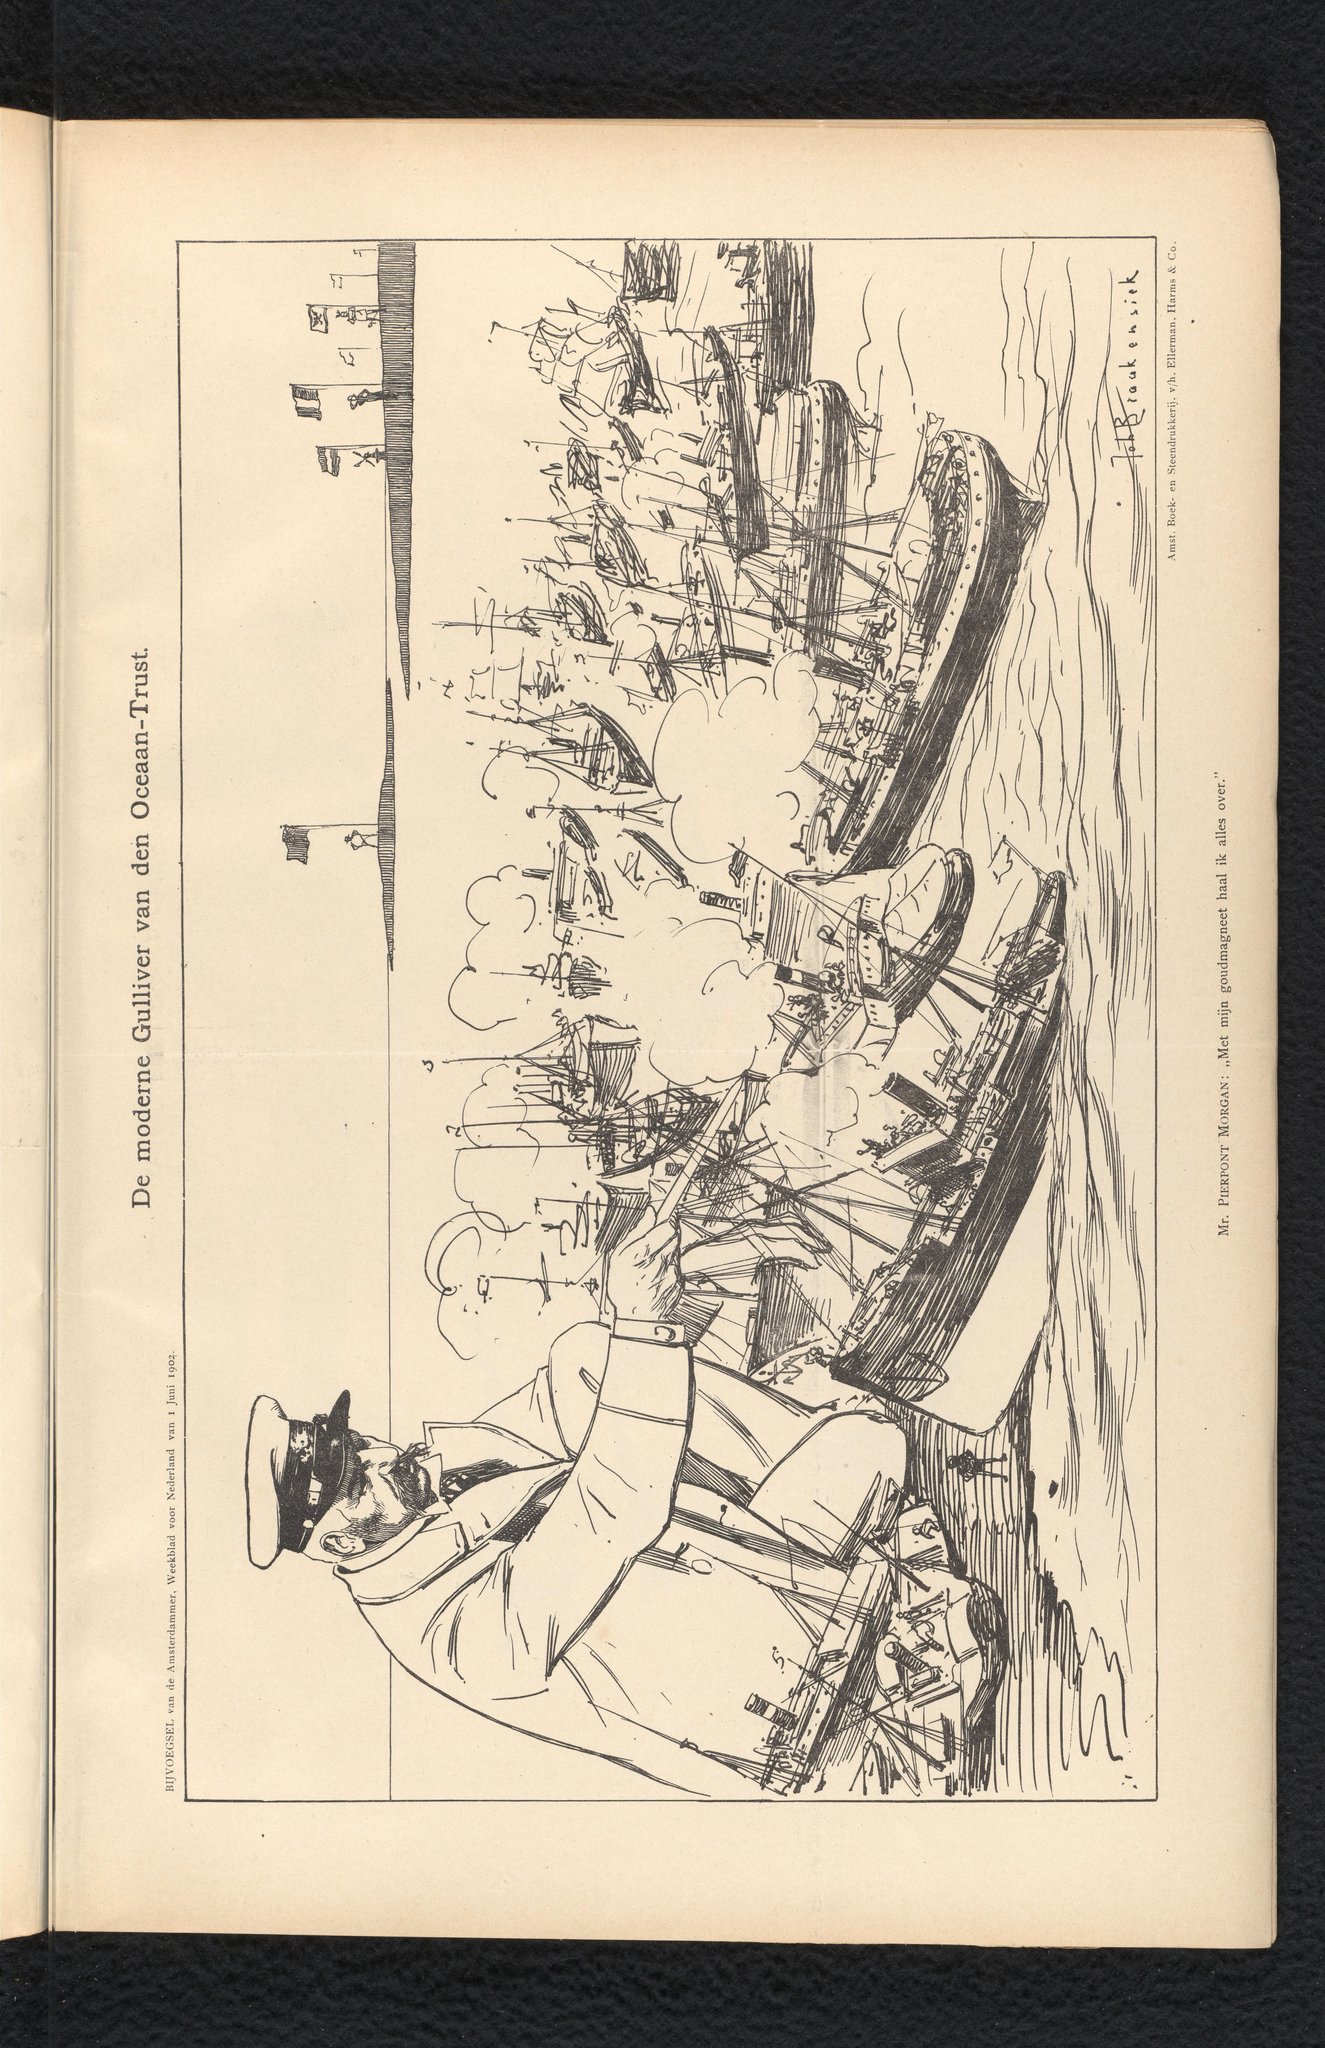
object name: cartoon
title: De moderne Gulliver van den Oceaan-Trust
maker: johan braakensiek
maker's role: draughtsman, print maker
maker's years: 1858-1940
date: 1902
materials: paper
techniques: lithograph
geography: amsterdam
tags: merchant shipping, shipping trade, political caricatures and satires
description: De Amerikaanse bankier John Pierpont Morgan trekt met zijn 'goudmagneet' alle schepen van de internationale koopvaardij naar zich toe.